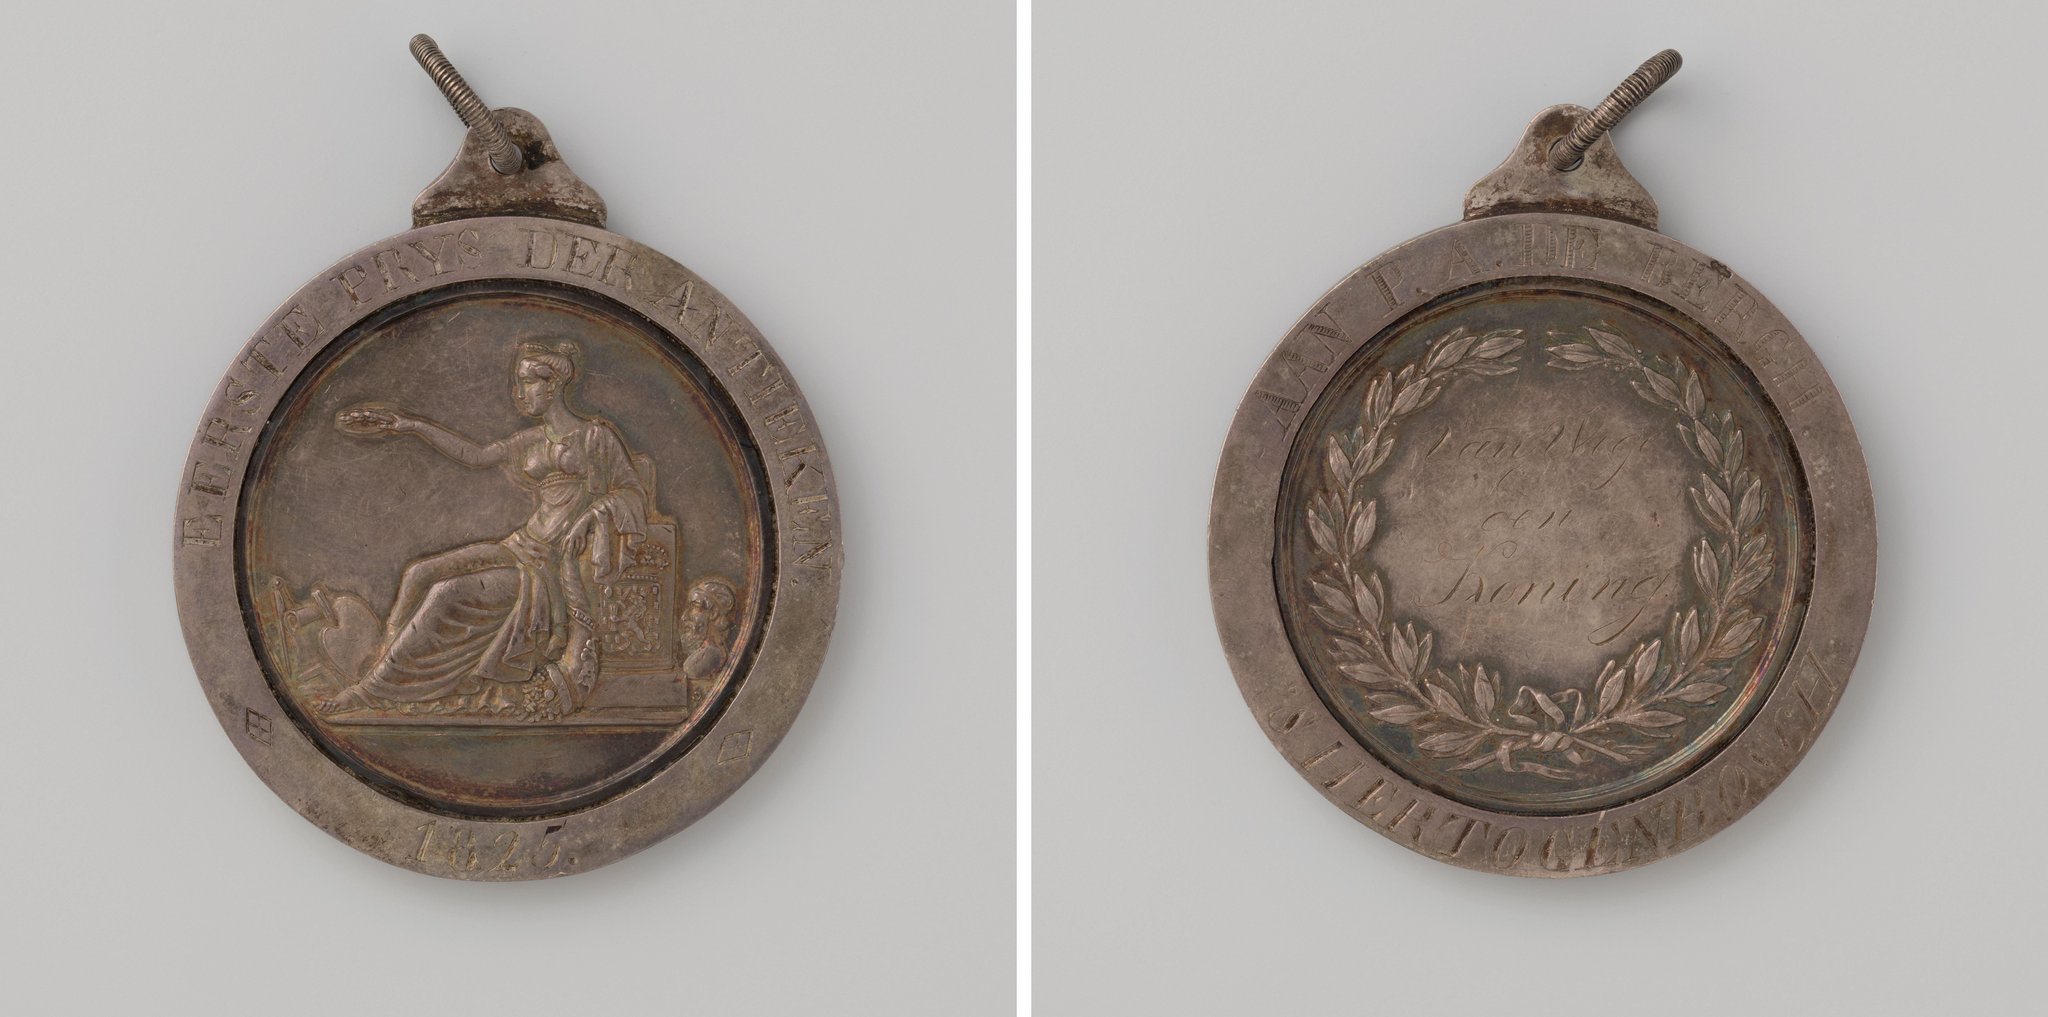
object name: medal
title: Tekenacademie van 's-Hertogenbosch, eerste prijs der antieken, uitgereikt aan P.A. de Bergh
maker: g.f. sartorius jr.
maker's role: painter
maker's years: 1799-1859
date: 1827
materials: silver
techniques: engraving, striking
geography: netherlands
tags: den bosch